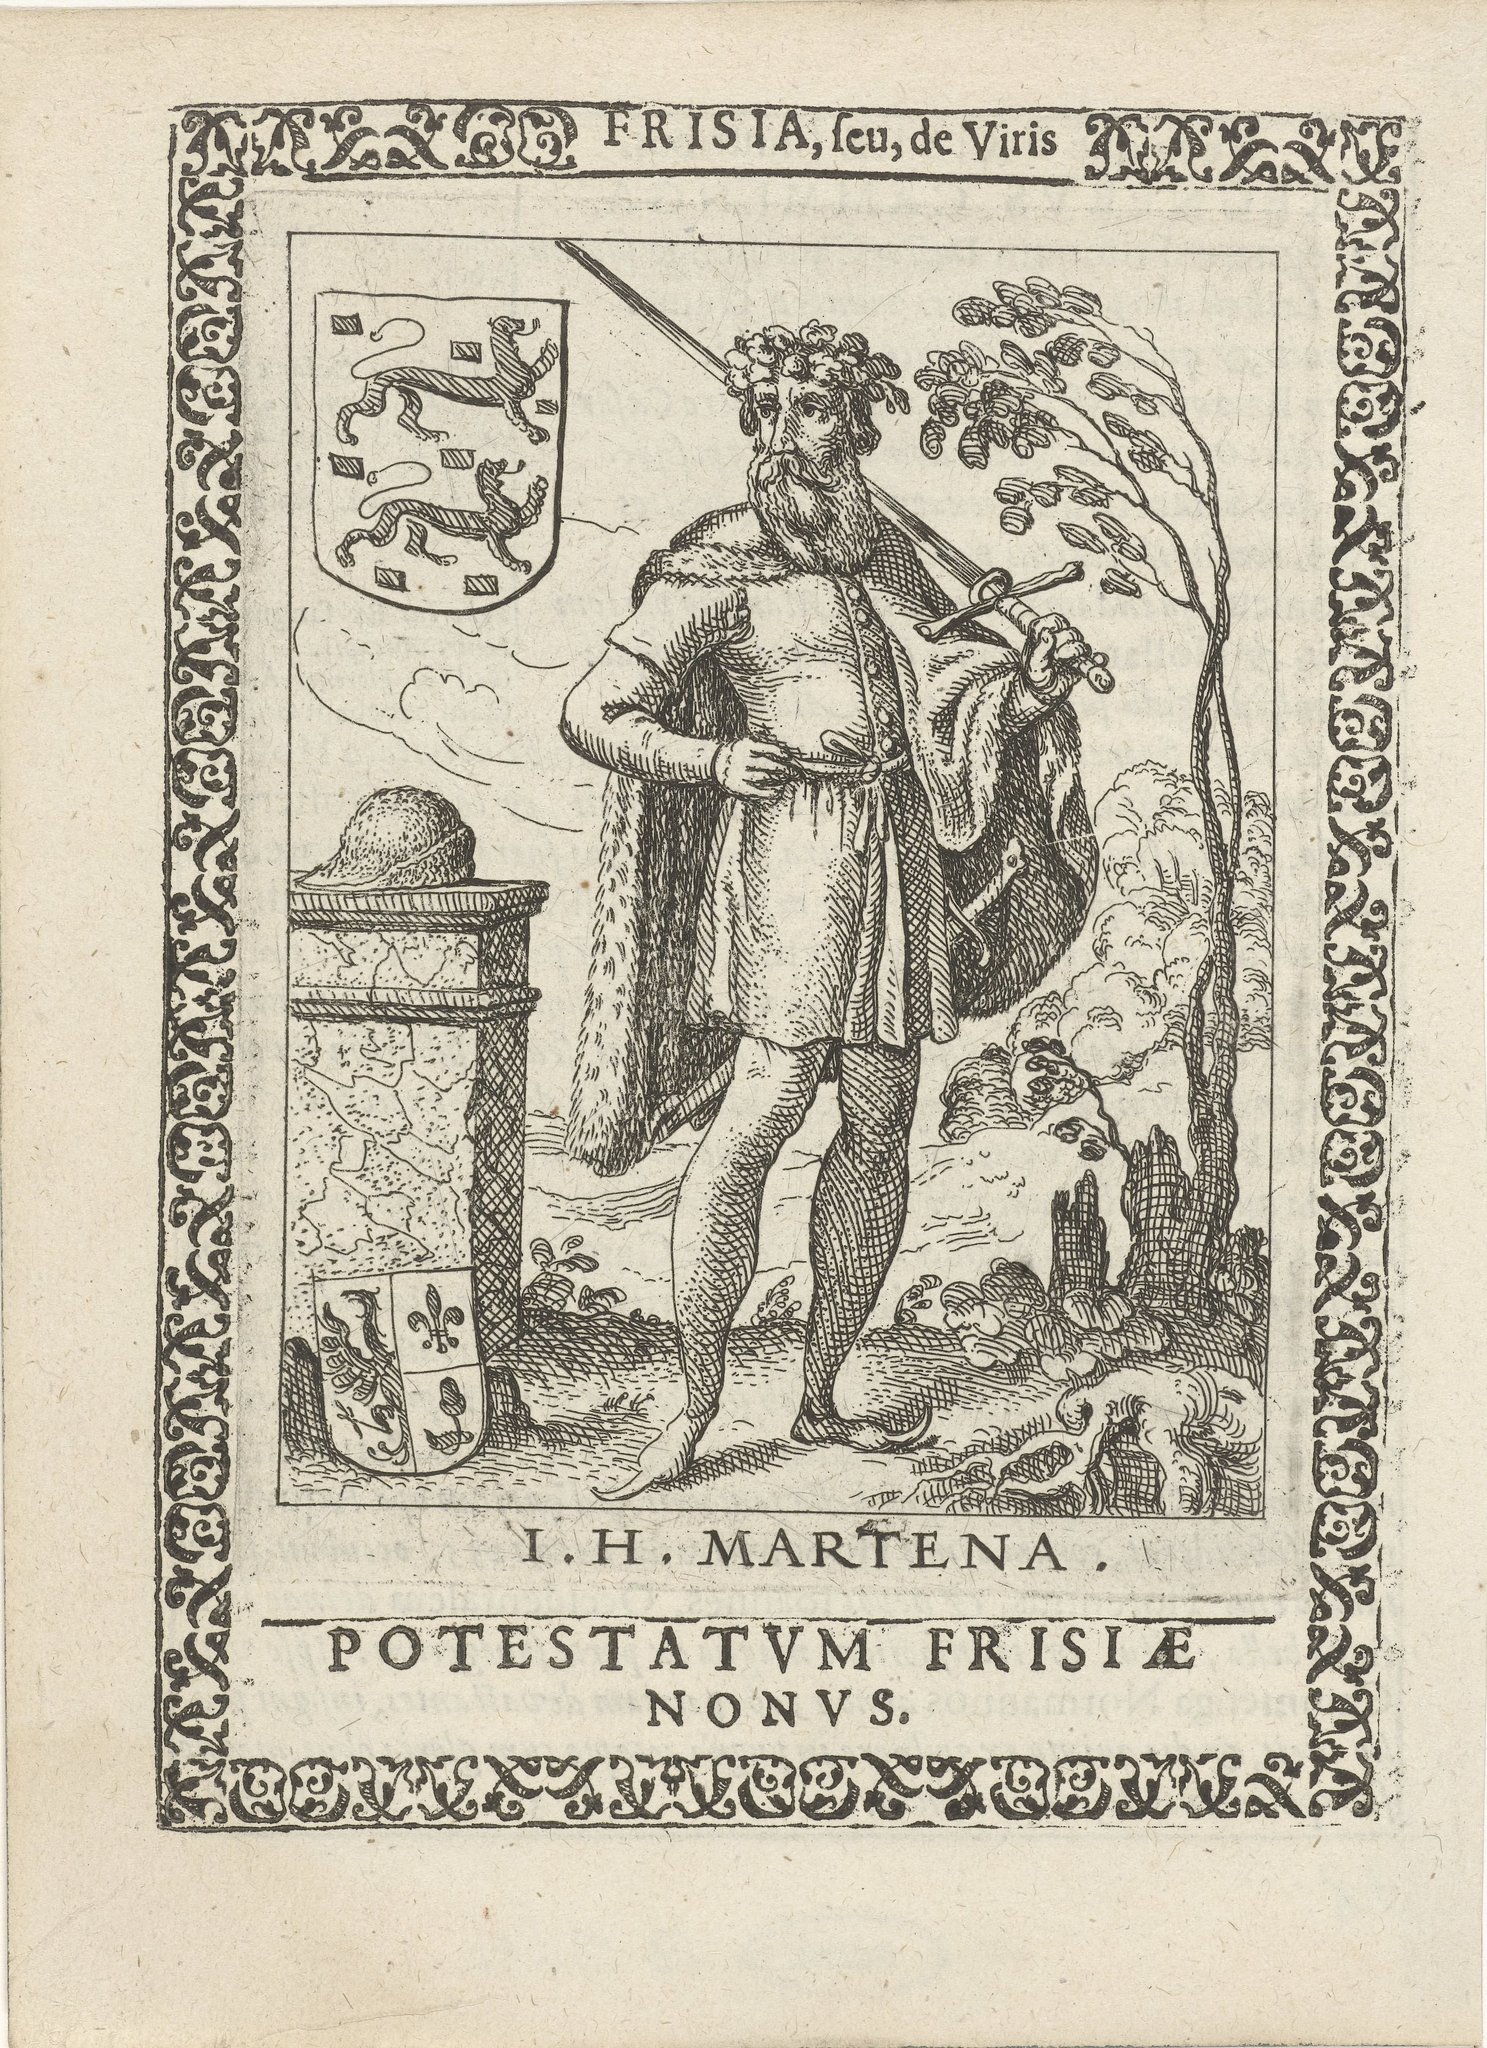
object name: print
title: I.H. Martena. Potestatum Frisiae Nonus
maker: pieter feddes van harlingen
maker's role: painter, print maker, publisher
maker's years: 1586-1623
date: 1618-1620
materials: paper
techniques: etching, letterpress printing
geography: friesland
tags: ruler, sovereign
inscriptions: collector's mark: Lugt 2228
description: Hessel Martena, negende potestaat van Friesland. Staande ten voeten uit, zwaard over de schouder, bladerkrans op het hoofd. Illustratie, met tekst op achterzijde, afkomstig uit het boek: Frisia seu de viris rebusque Frisiae illustribus libri duo.